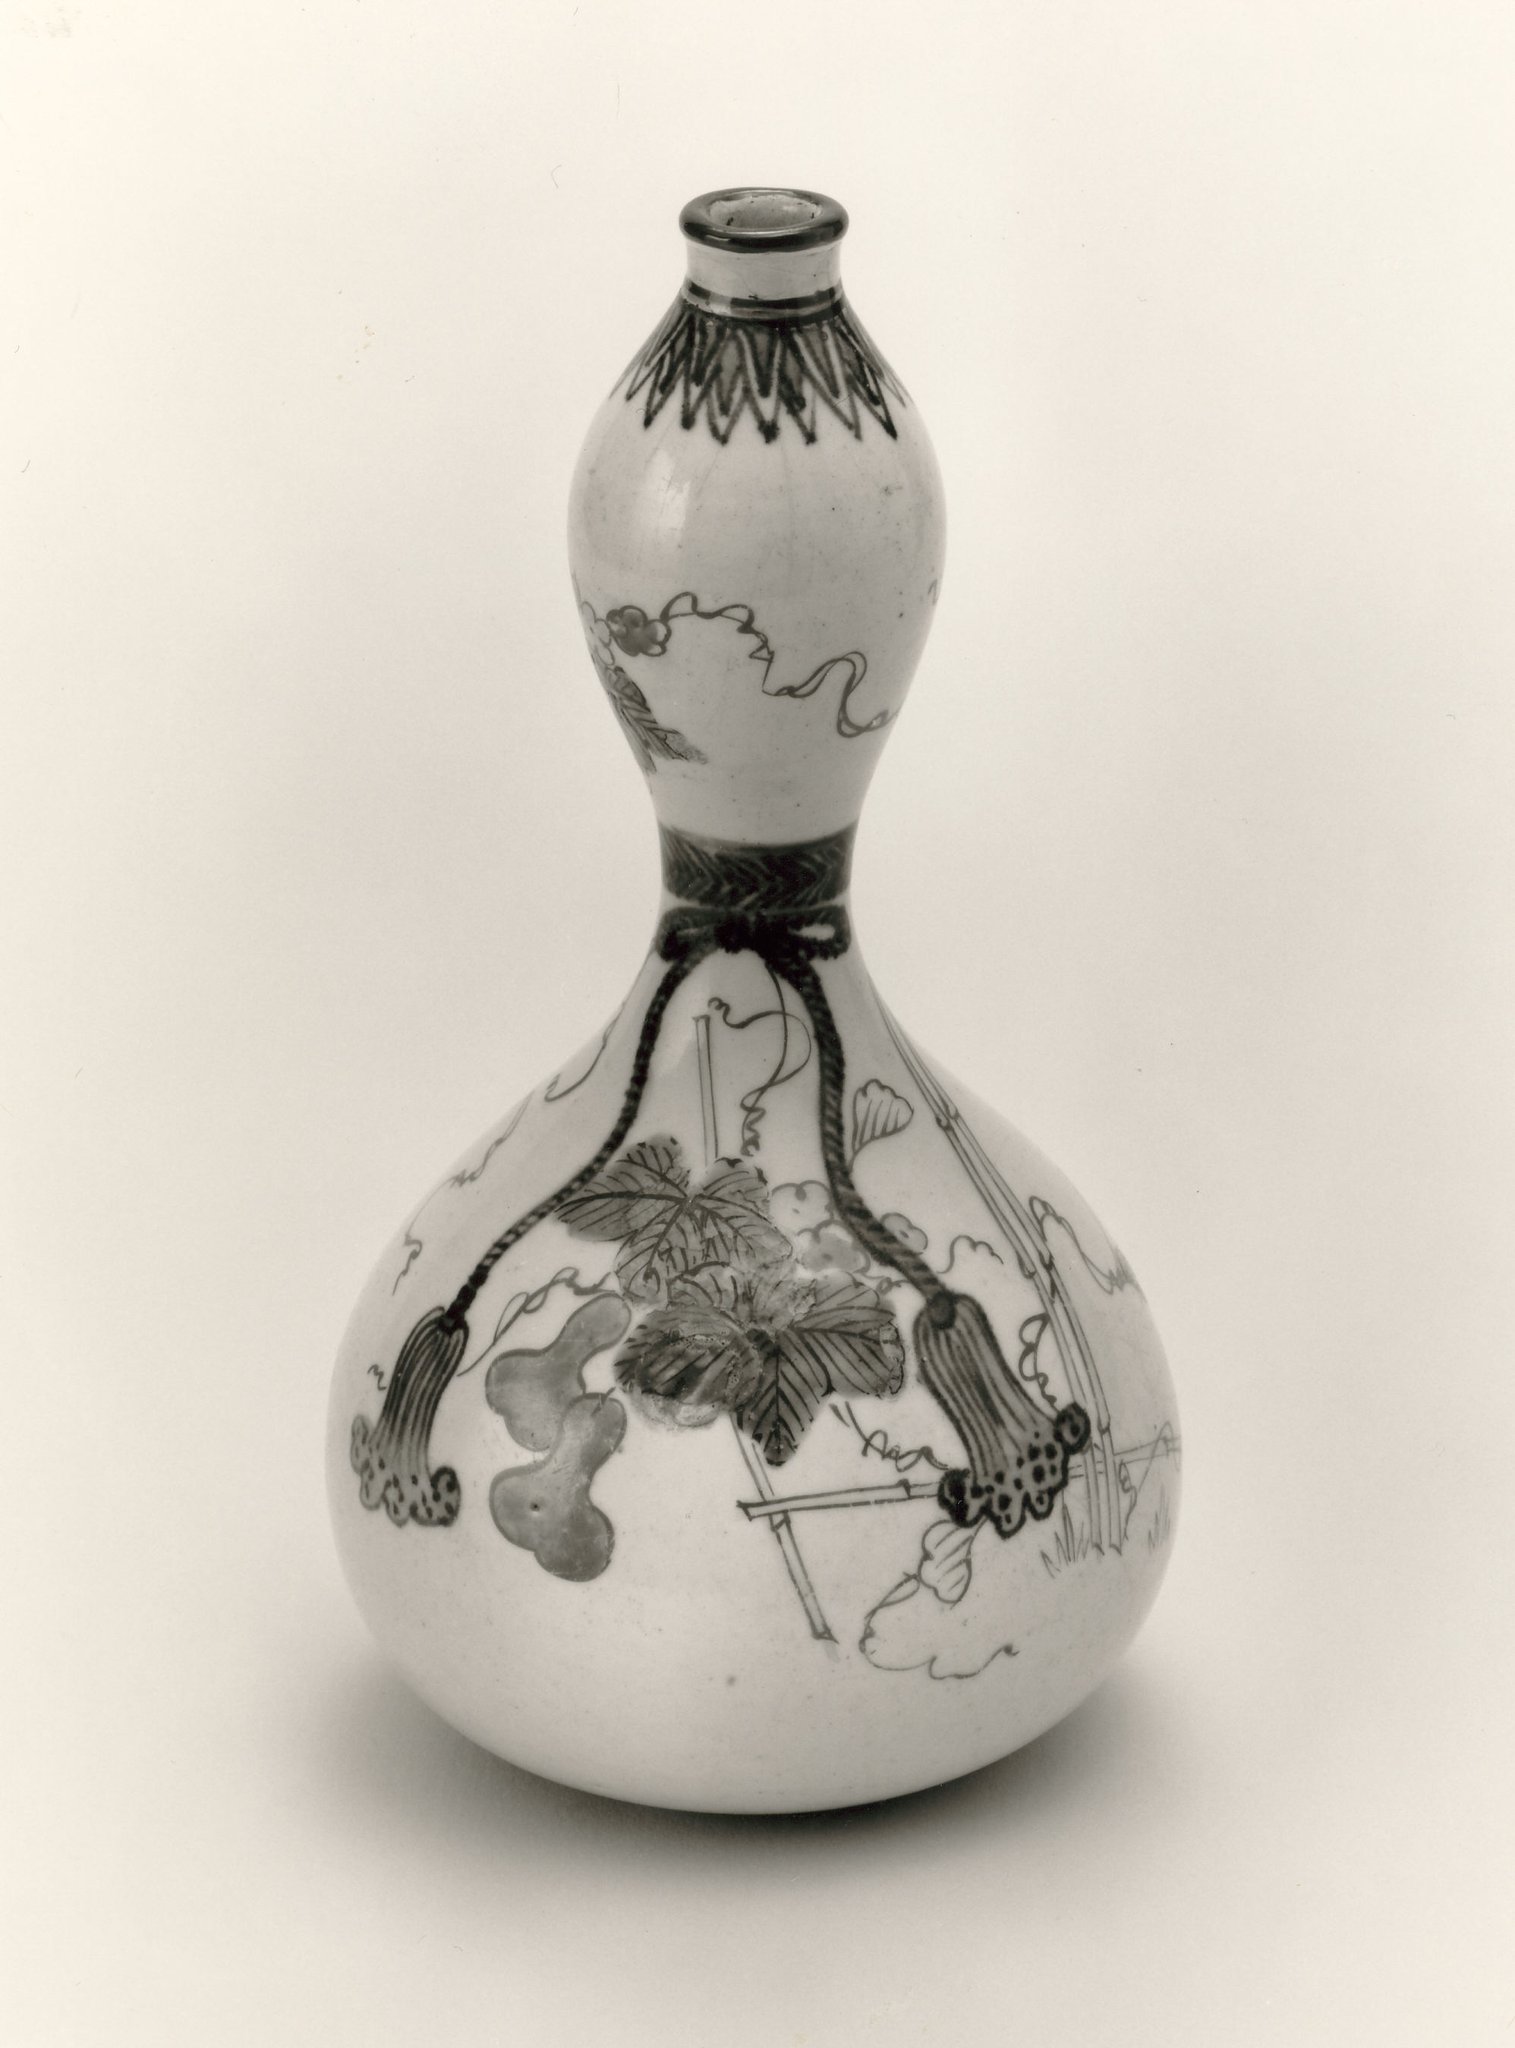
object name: sake bottle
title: Sake Bottle in the Shape of a Gourd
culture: japanese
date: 1667-1700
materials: enamel, porcelain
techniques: overglaze, underglaze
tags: fruit